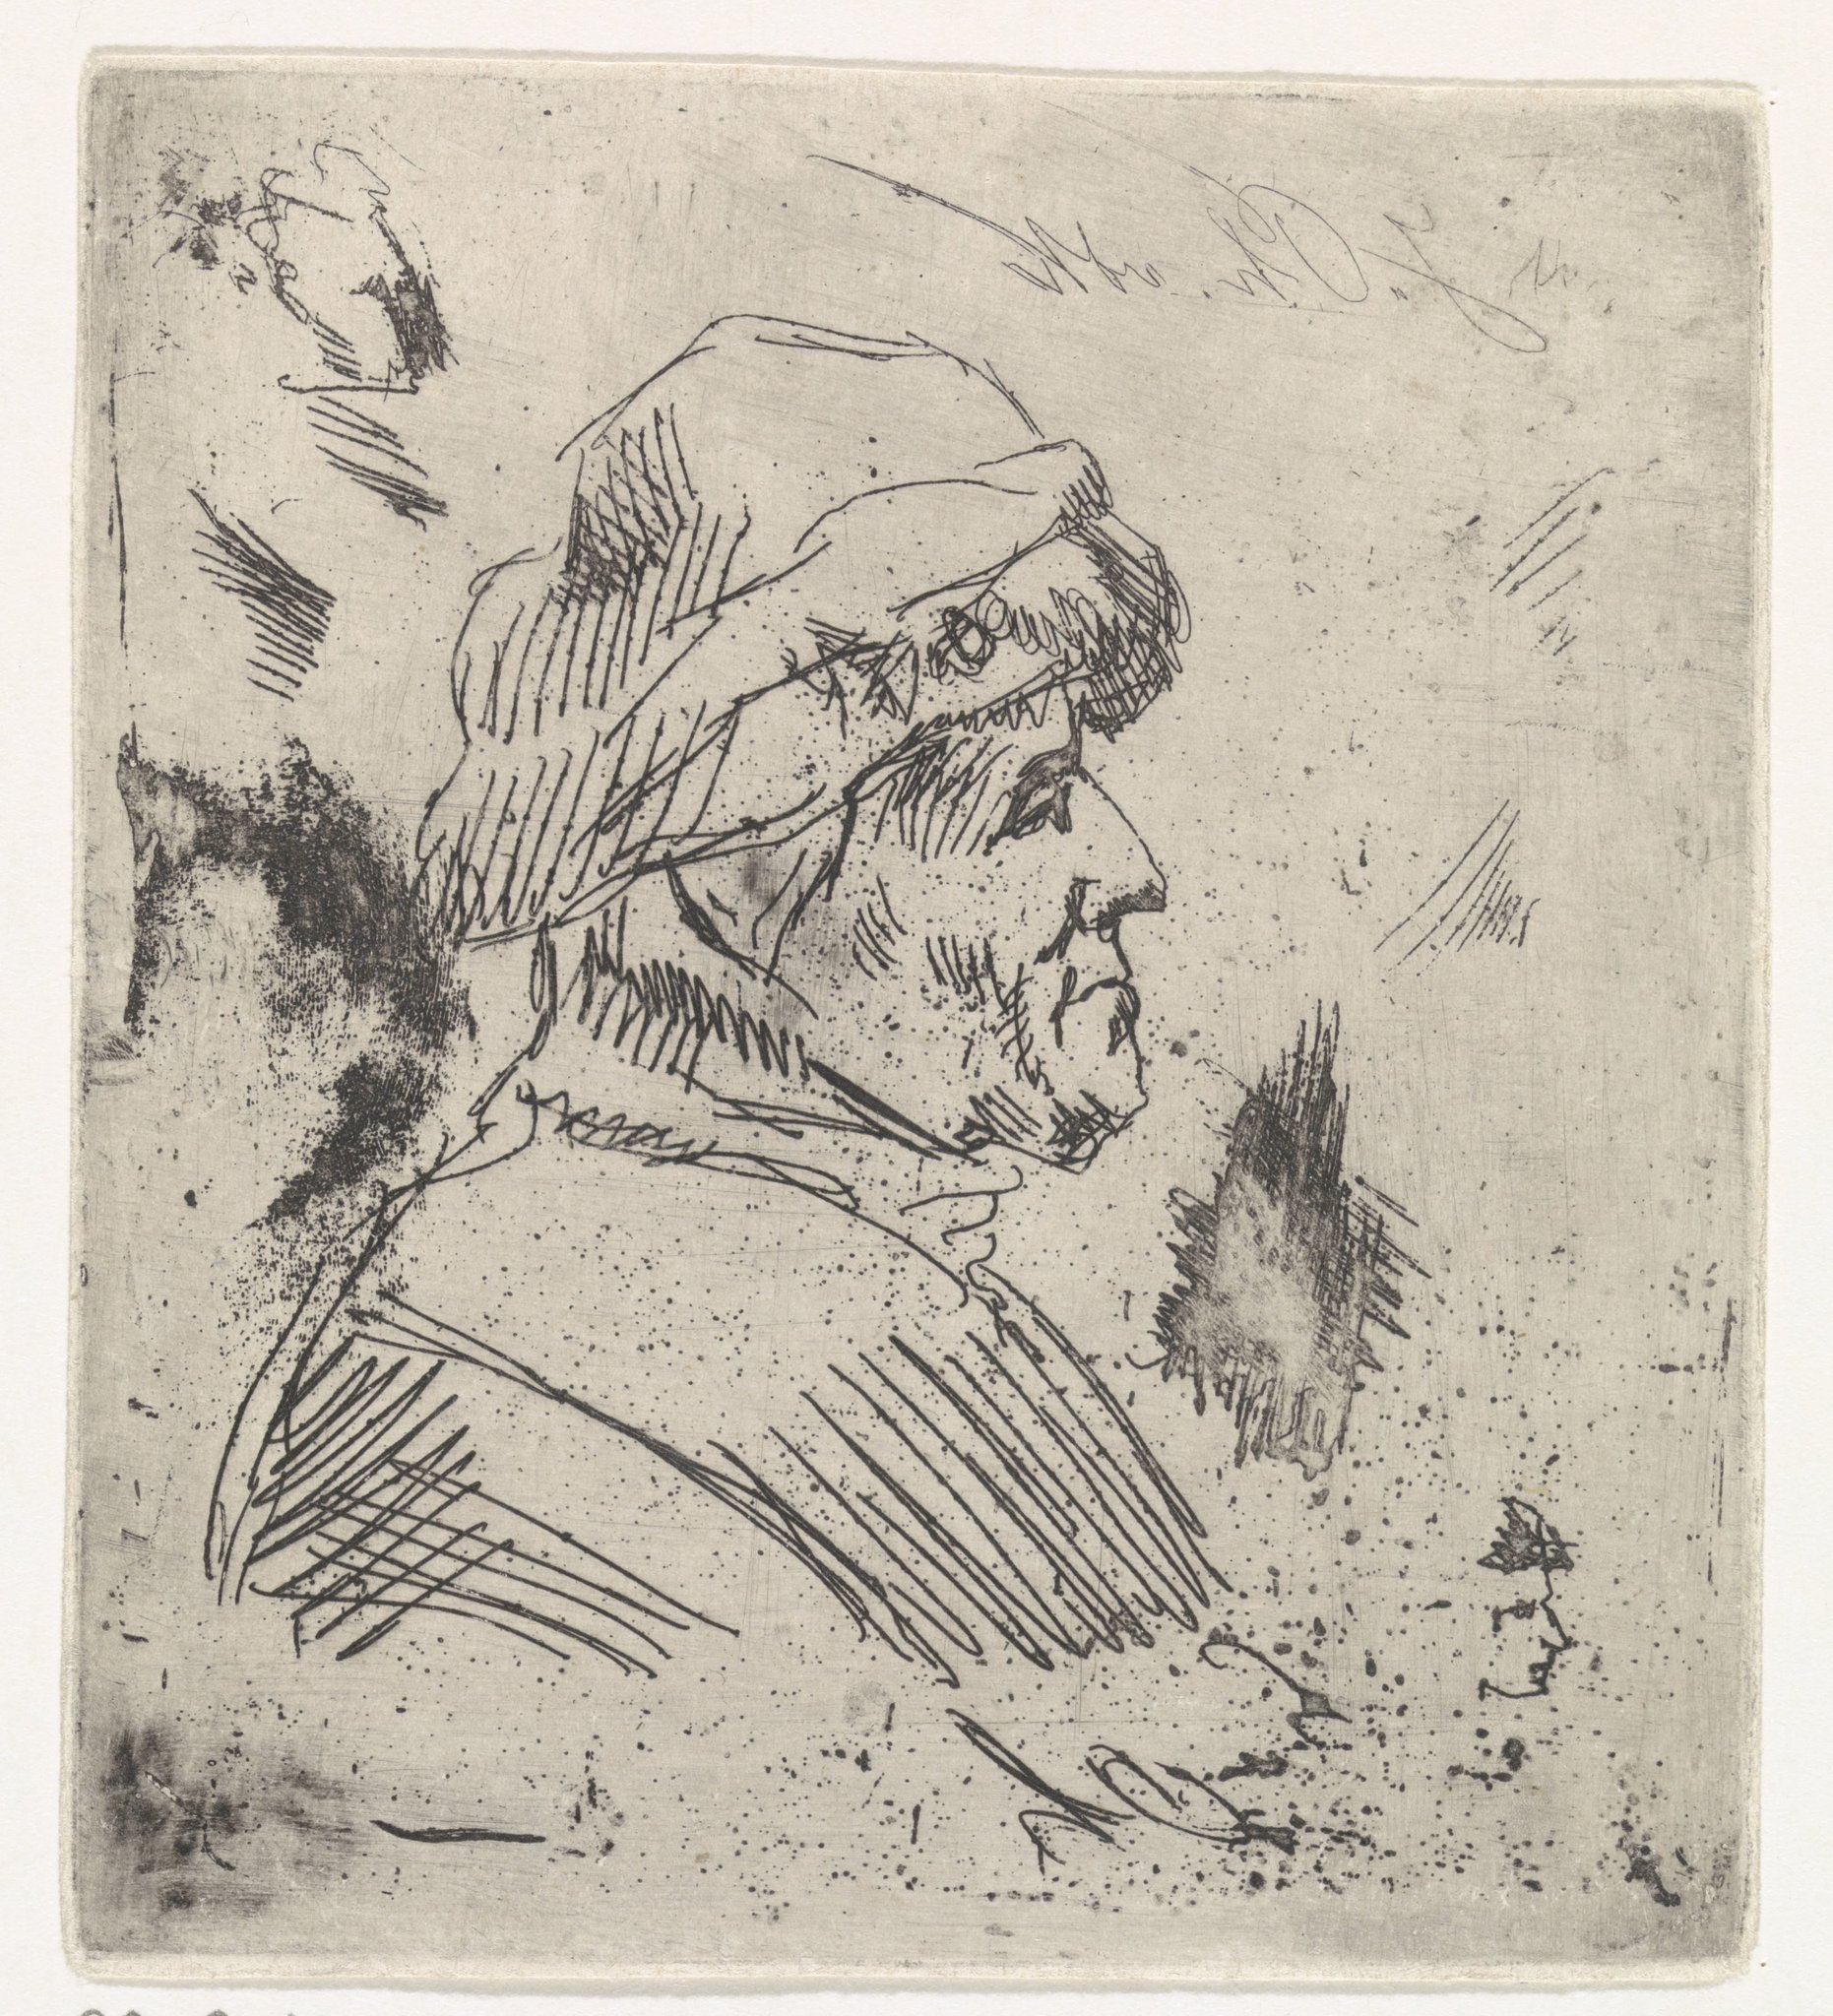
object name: print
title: Studieblad met mannenkop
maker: johan philip van der kellen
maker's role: draughtsman, print maker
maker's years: 1831-1906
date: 1841-1906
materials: paper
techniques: etching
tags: head-gear, adult man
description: Studieblad met een mannenkop met muts en rechts onder een gezicht terzijde gezien.